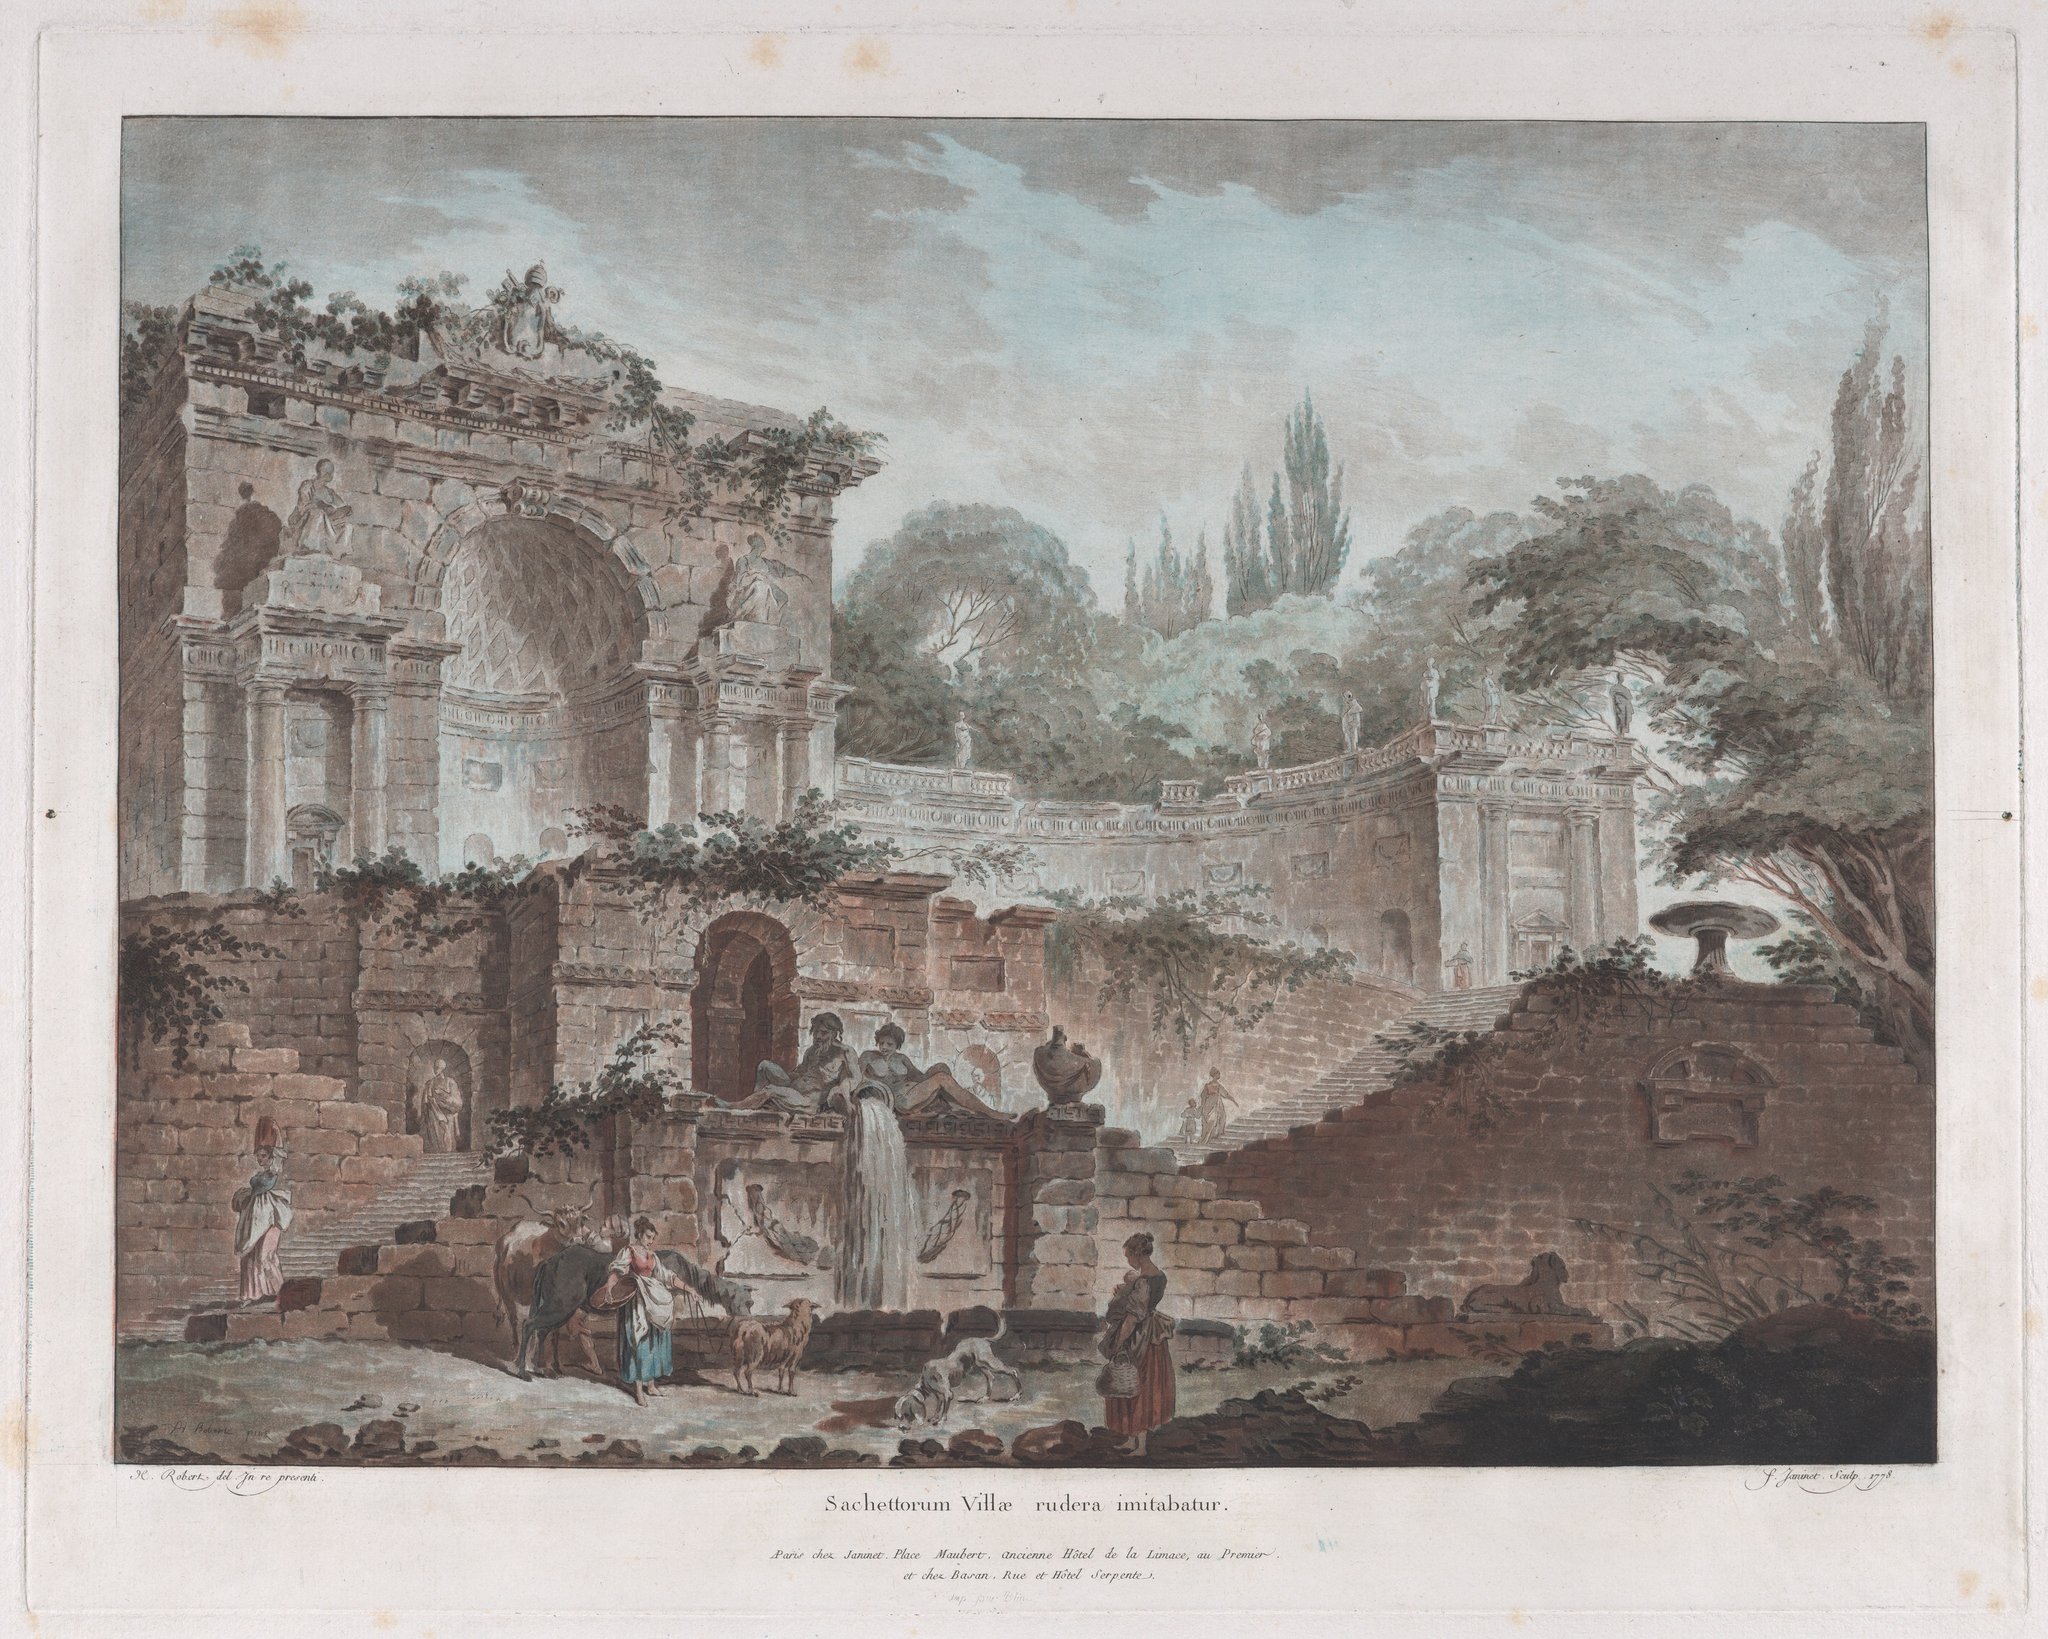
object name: print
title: The Villa Sachetti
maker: jean françois janinet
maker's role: artist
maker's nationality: french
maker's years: 1752-1814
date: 1778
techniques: mezzotint, printing